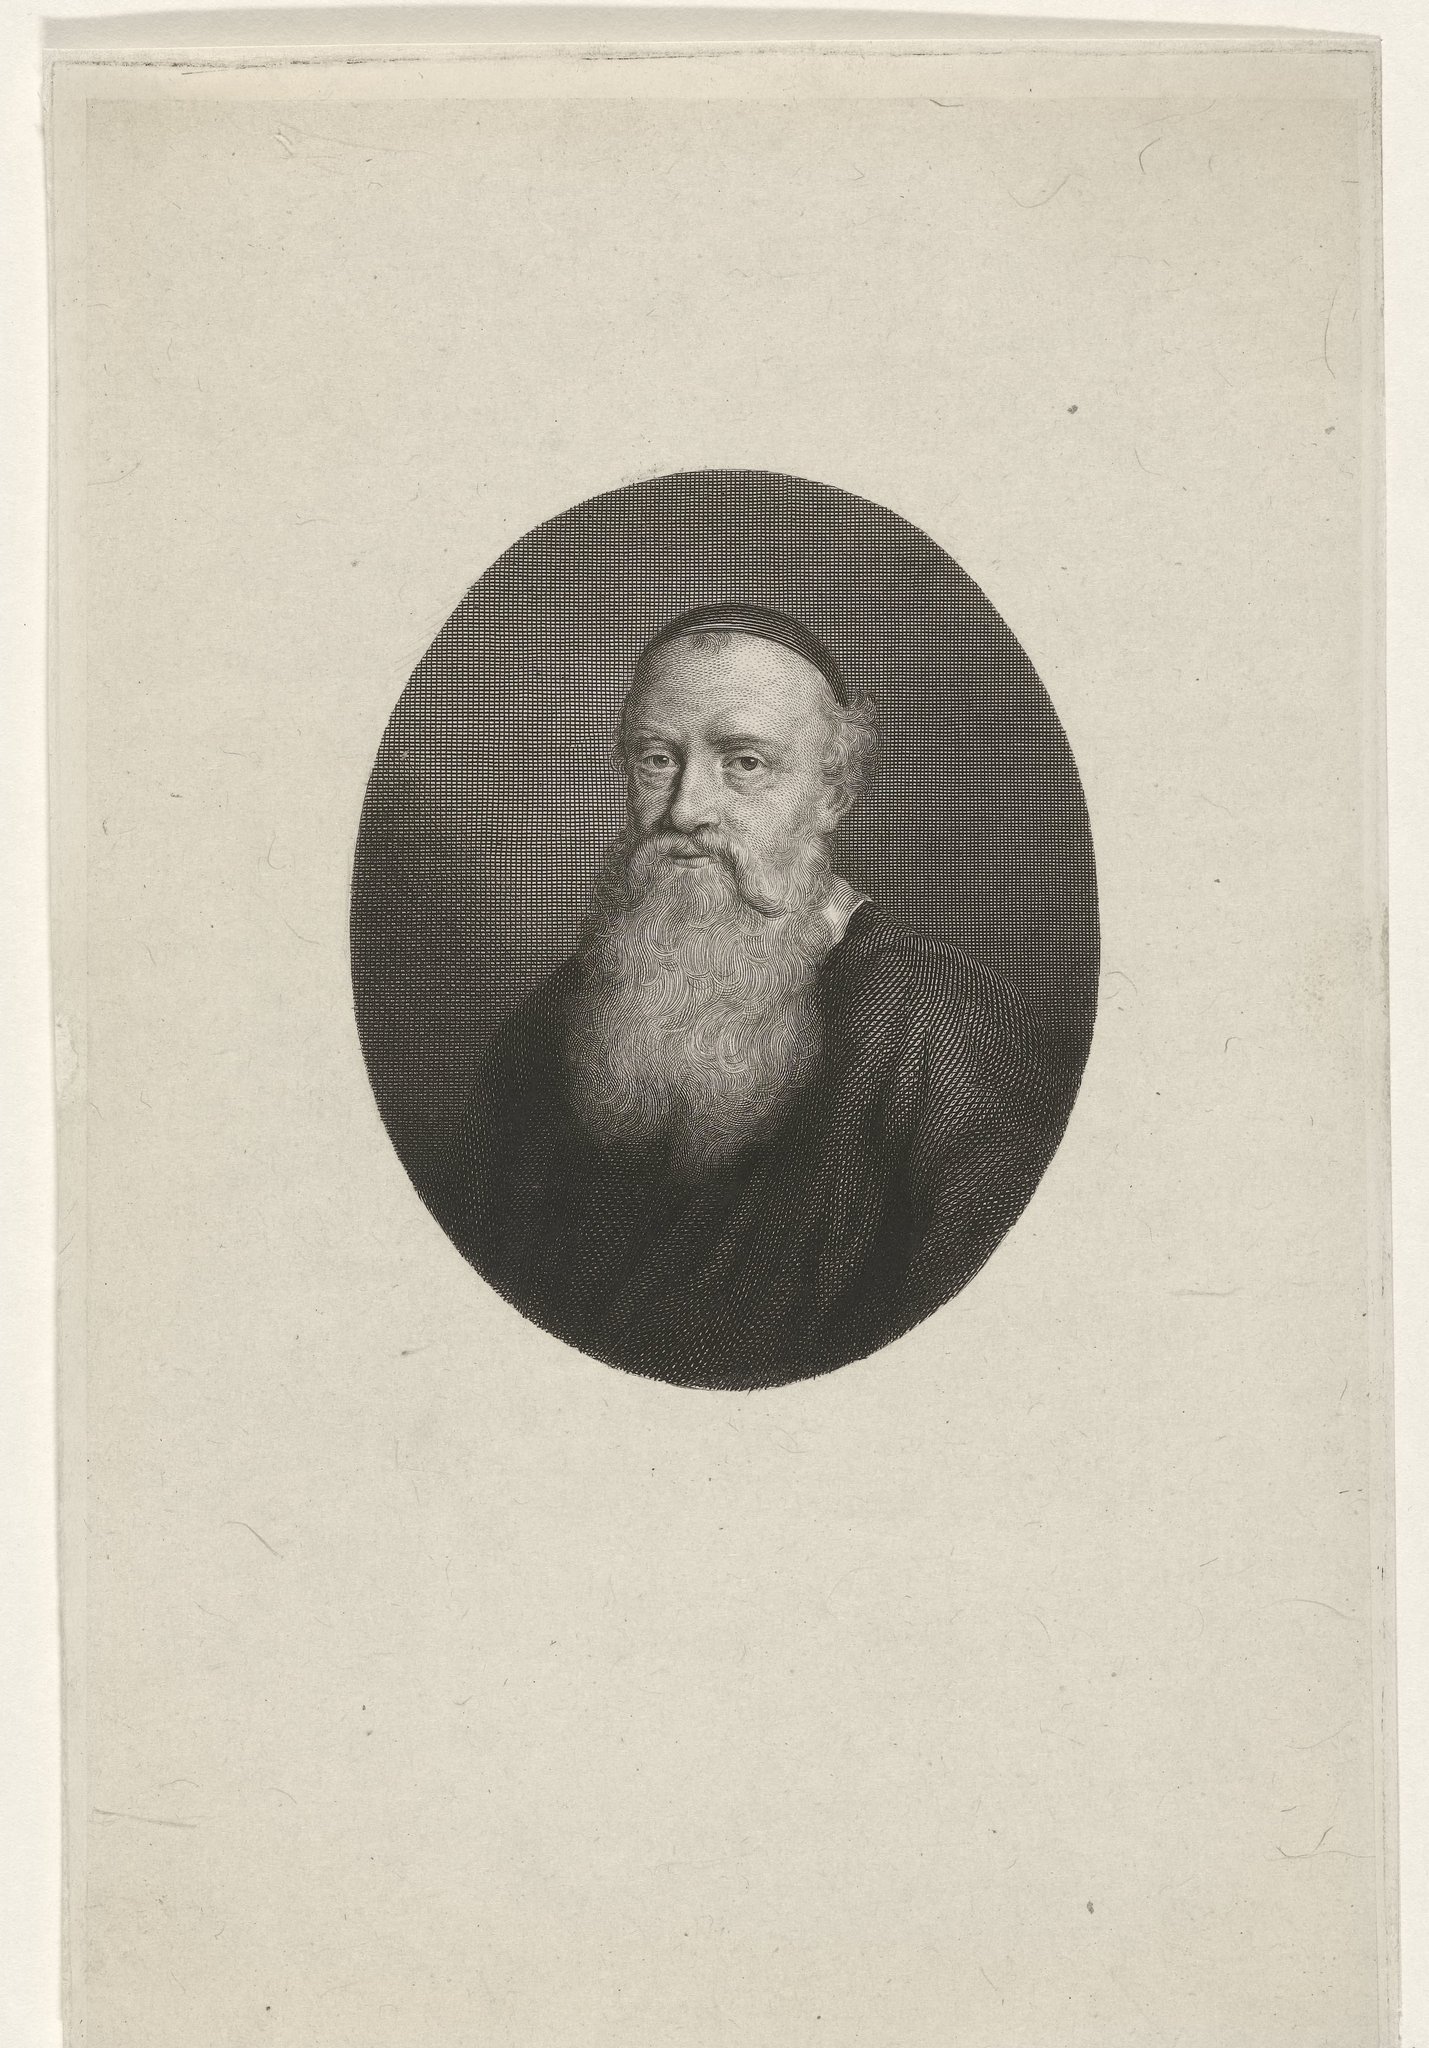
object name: print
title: Portret van Menno Simons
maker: johannes philippus lange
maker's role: print maker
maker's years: 1810-1849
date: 1820-1849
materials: paper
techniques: engraving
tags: clergyman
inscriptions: collector's mark: Lugt 2228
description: Portretbuste in ovaal naar links van Menno Simons, leider van de Mennonieten, met kalot.